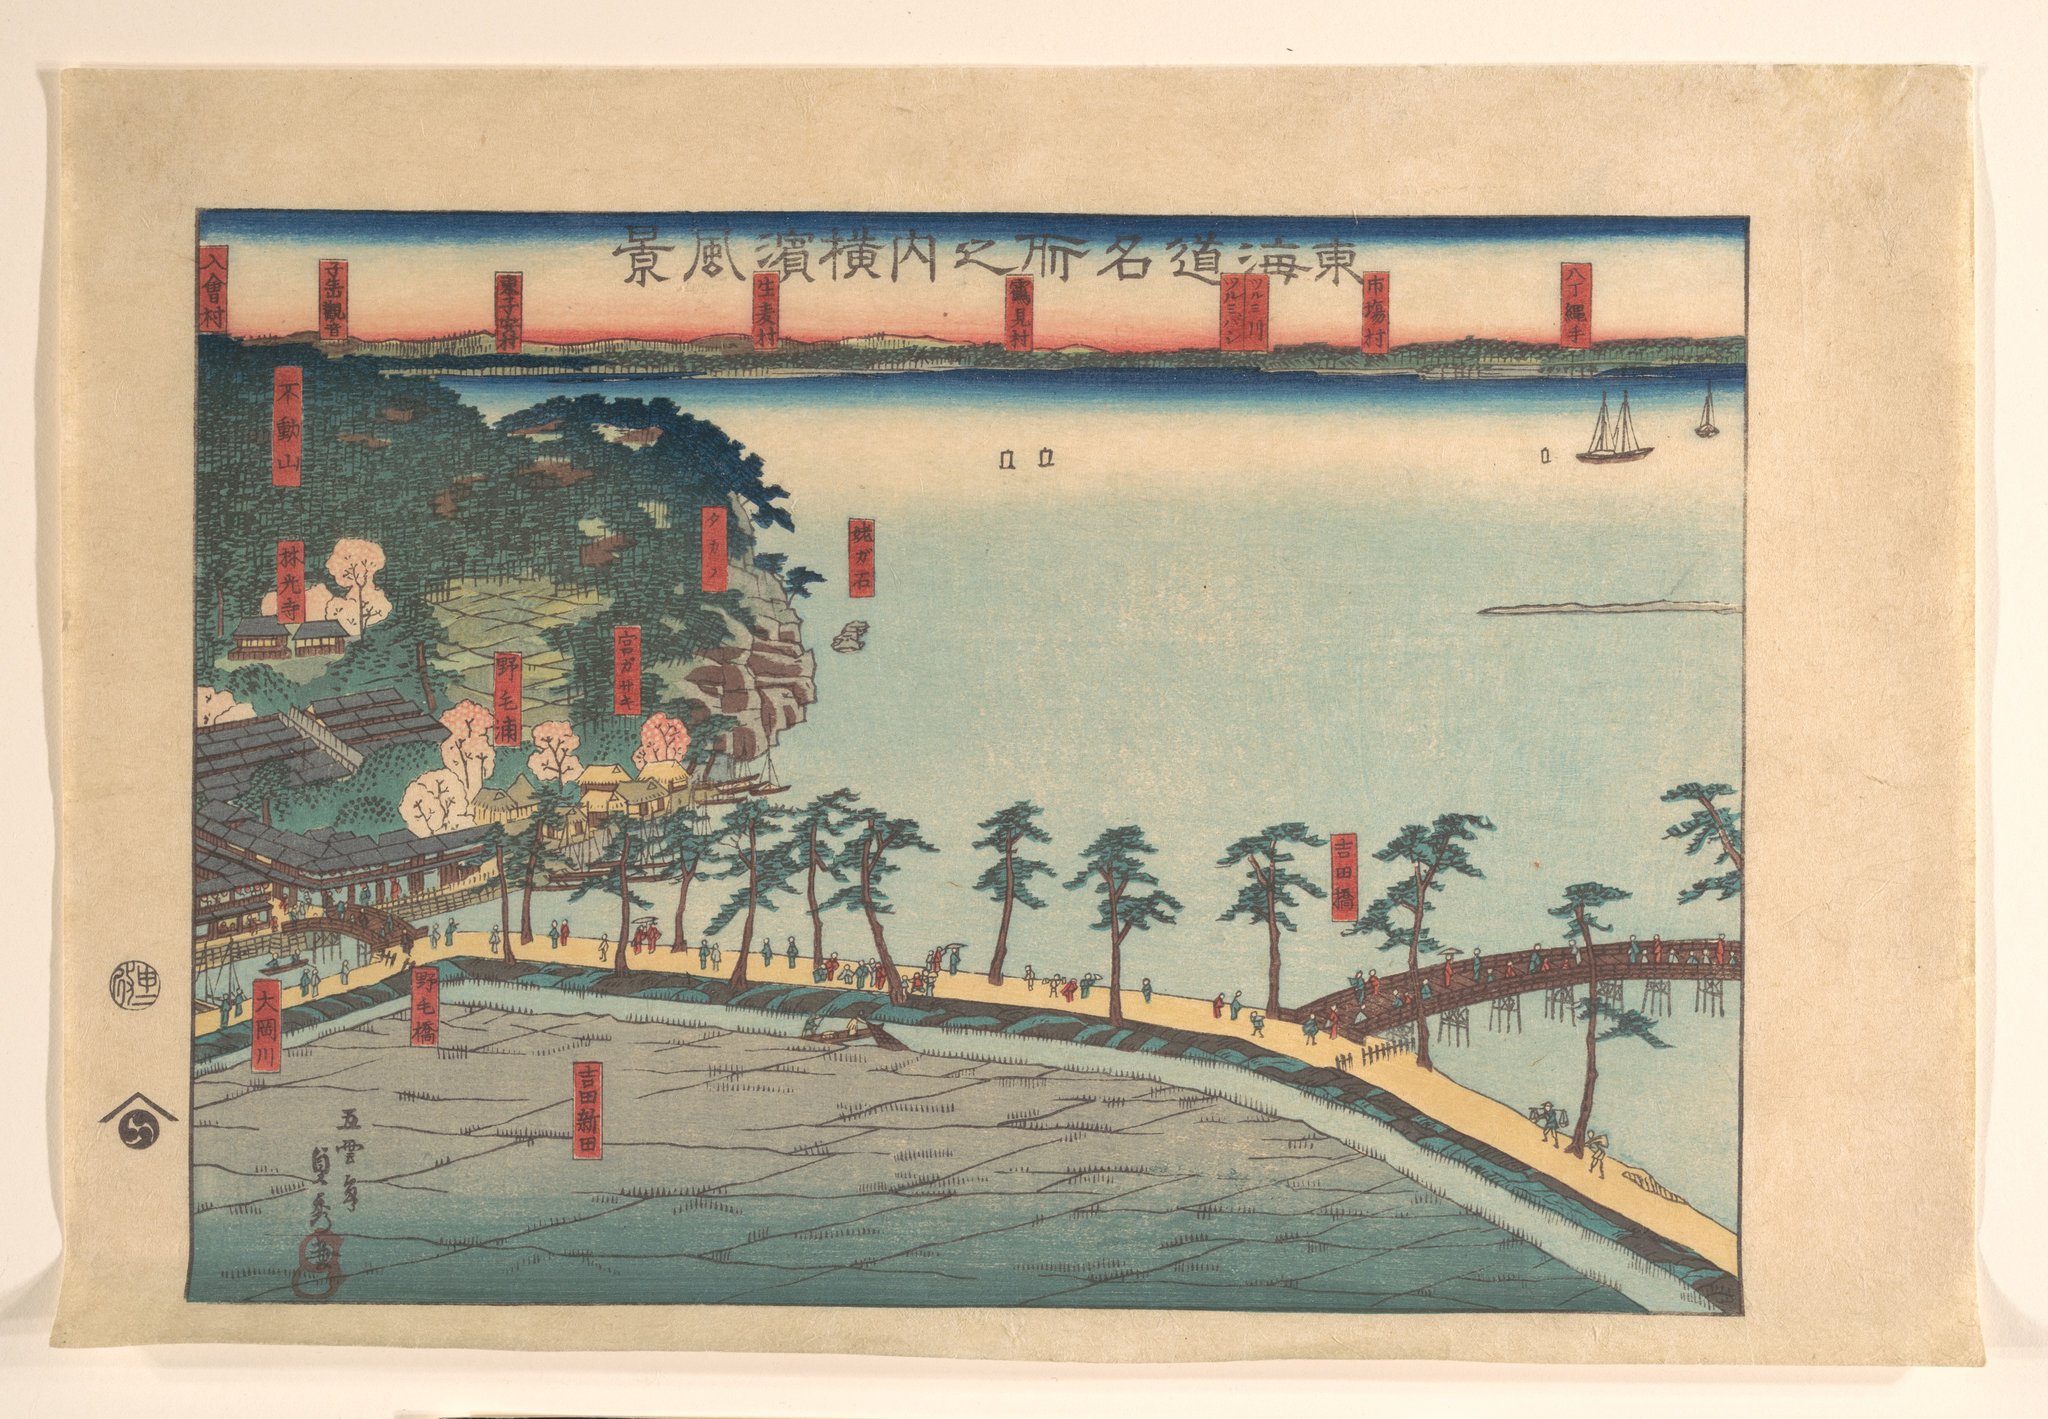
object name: print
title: Landscape View at Yokohama (Yokohama fūkei)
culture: japanese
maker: utagawa (gountei) sadahide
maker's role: artist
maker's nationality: japanese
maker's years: 1807-1873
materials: ink, paper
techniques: woodblock print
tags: human figures,bridges,landscapes